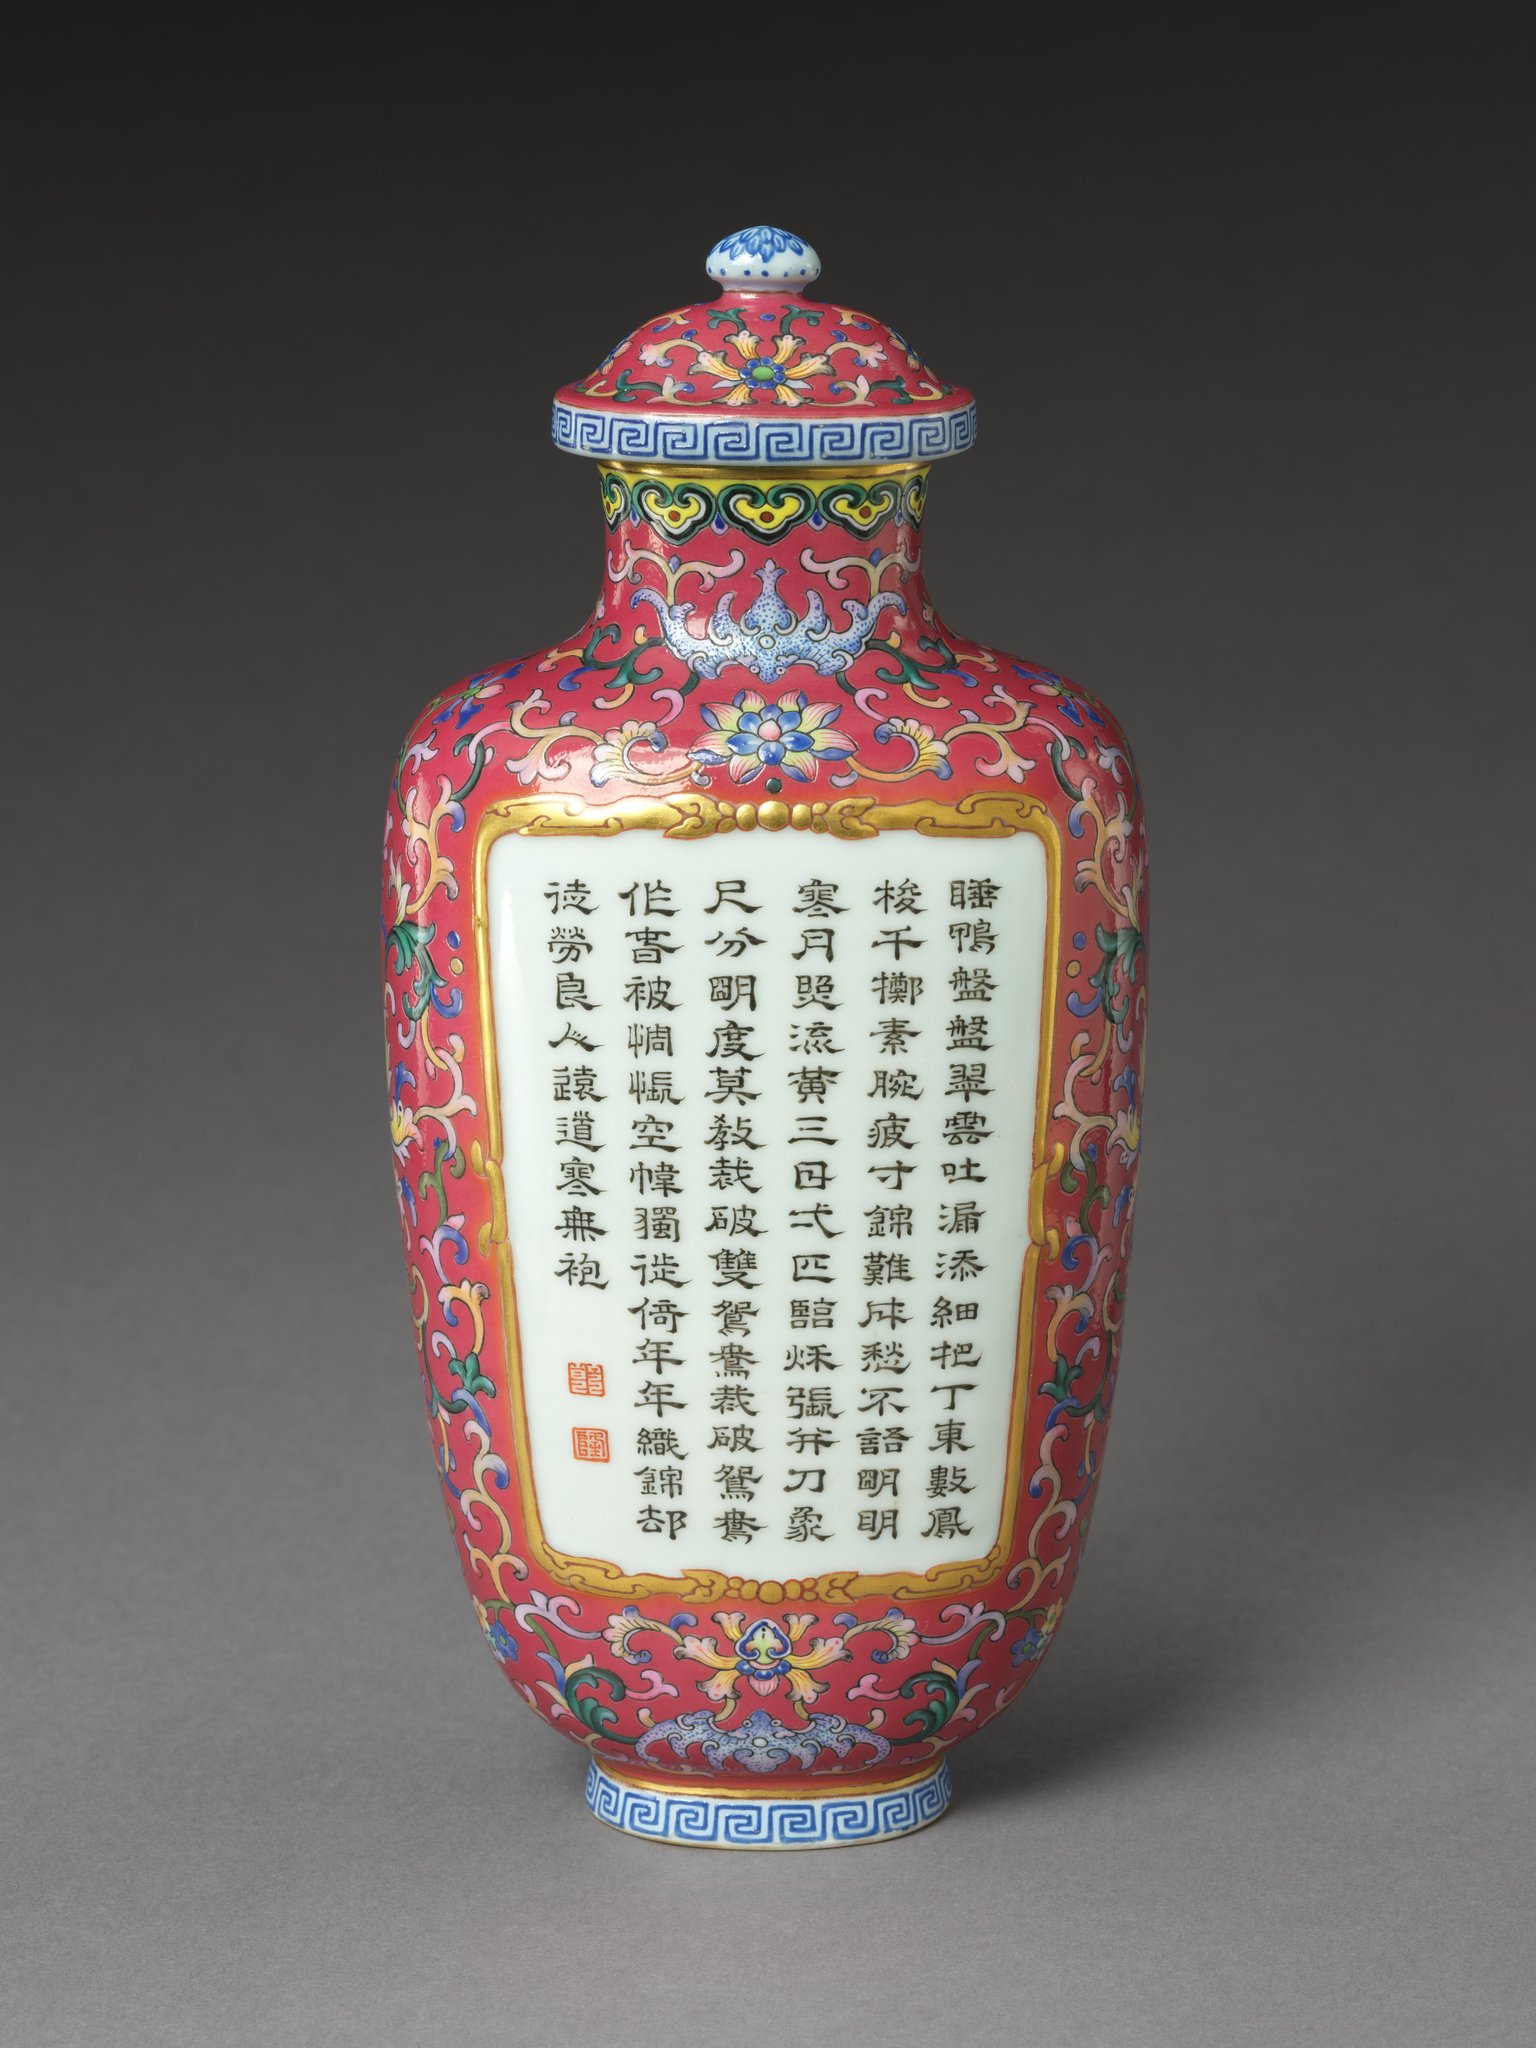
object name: vase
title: Vase with Poems Composed by the Qianlong Emperor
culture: chinese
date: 1767-1800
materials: enamel, porcelain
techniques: gilding, overglaze, painting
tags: poetry